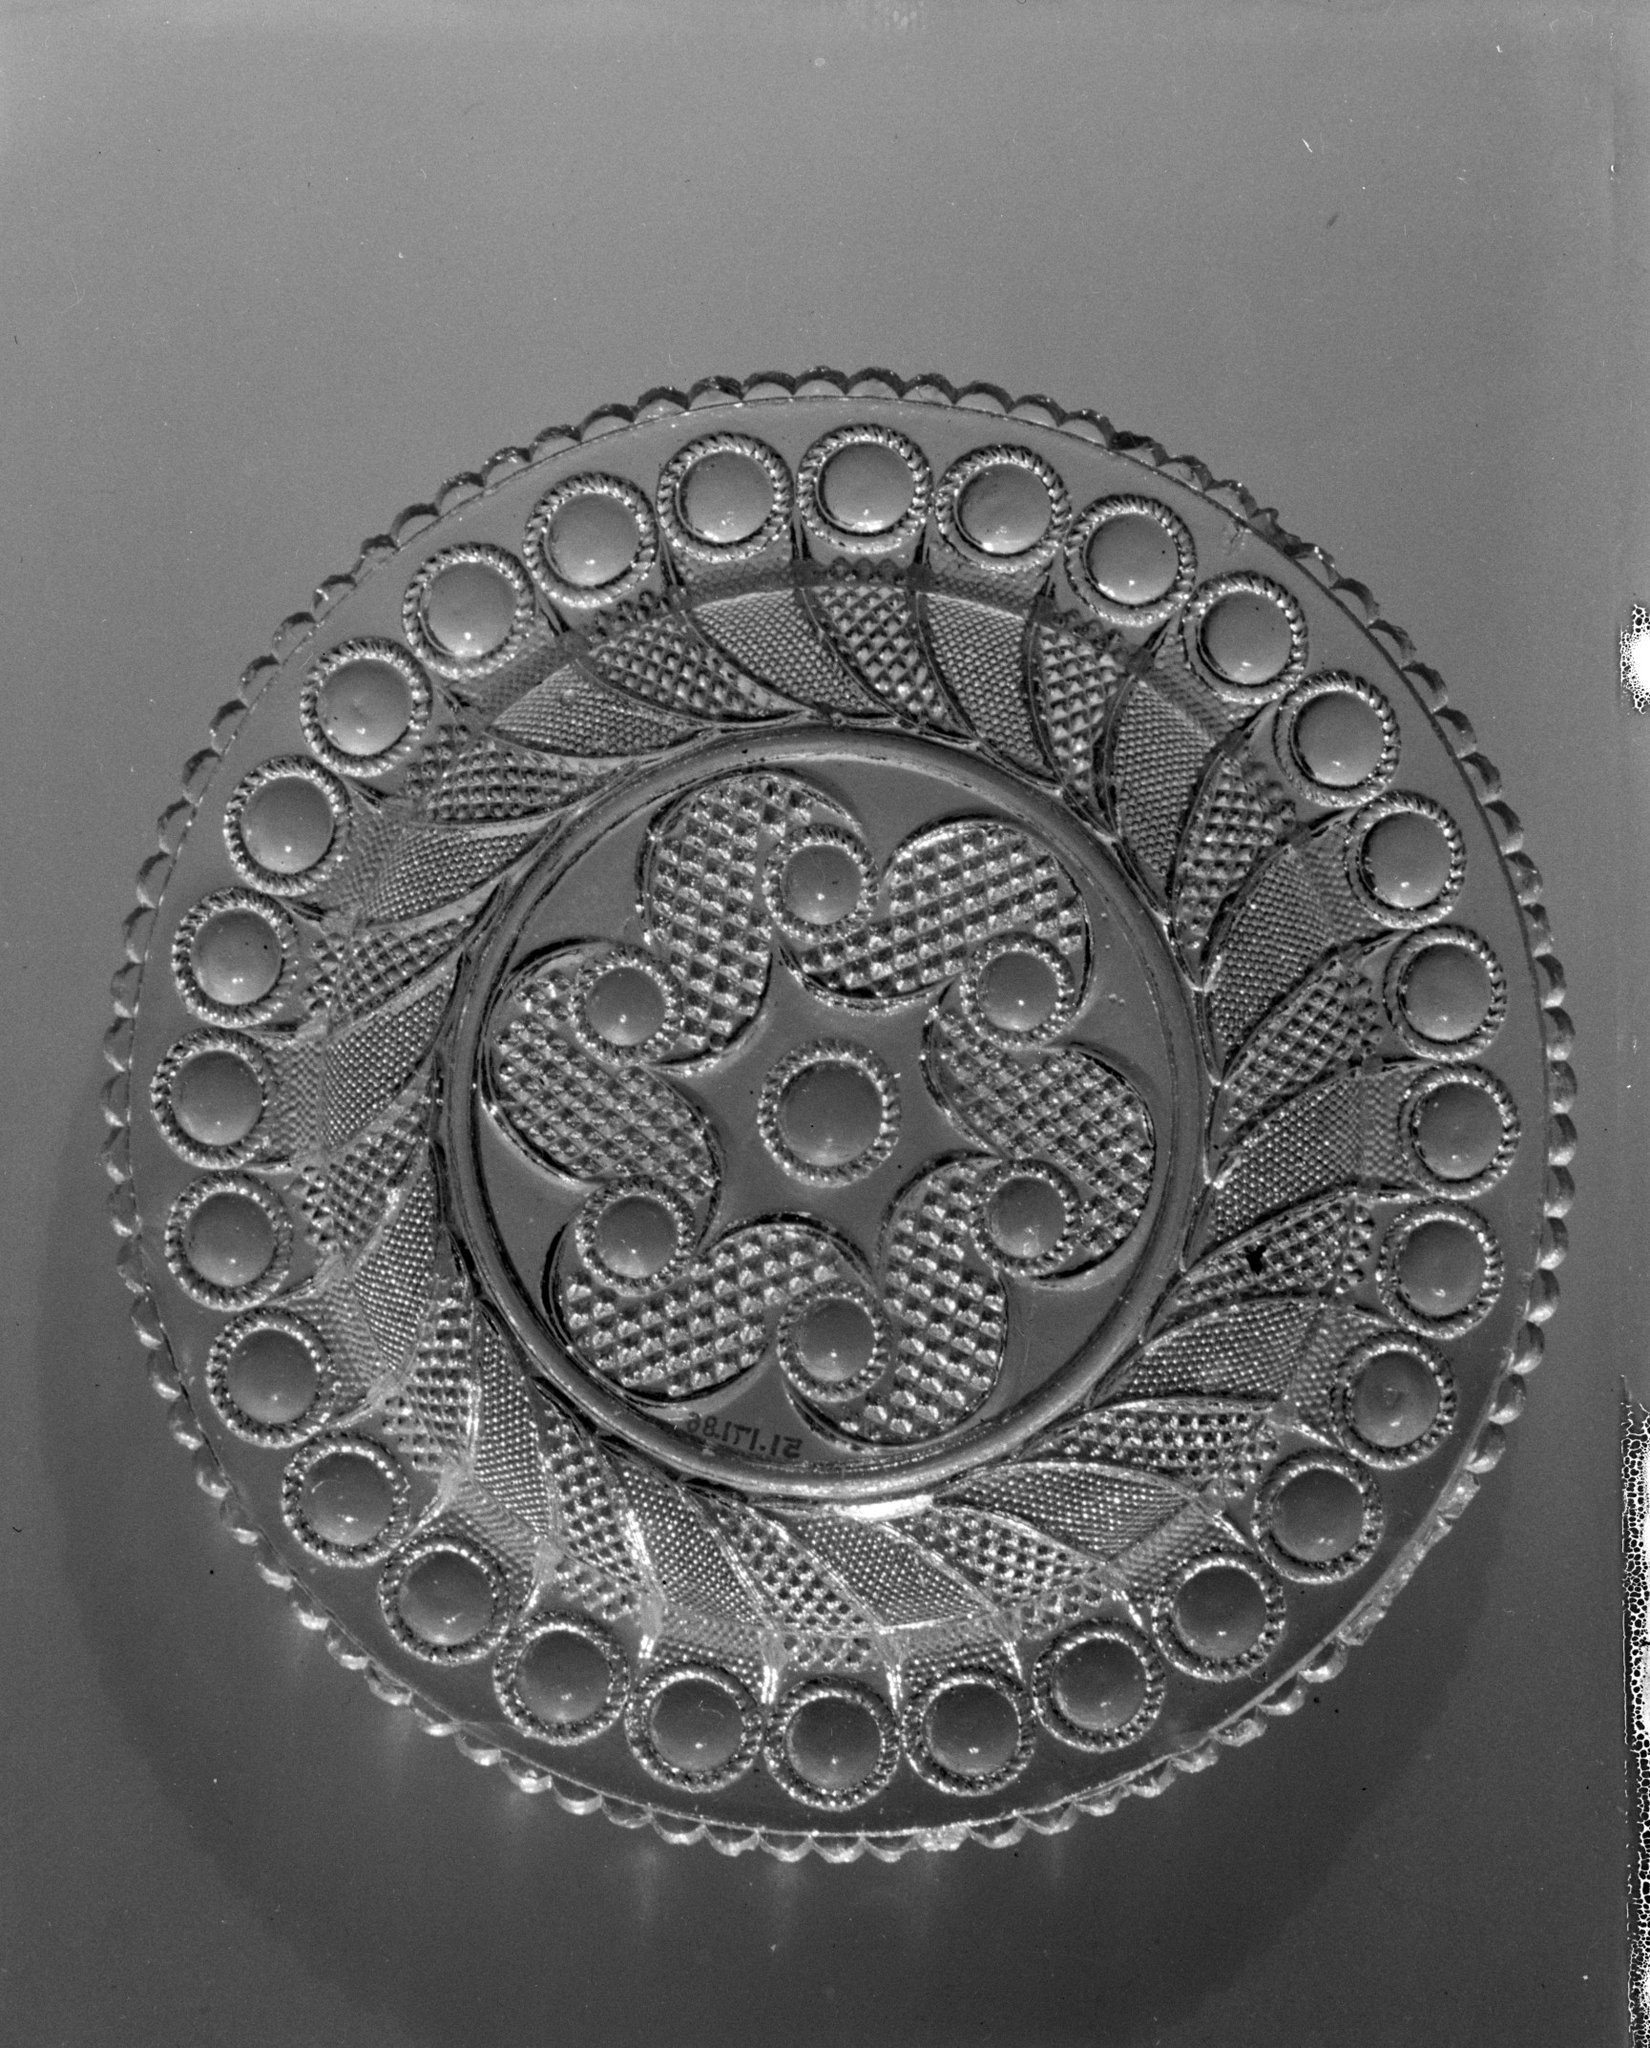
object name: plate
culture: american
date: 1835-1840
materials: glass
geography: united states